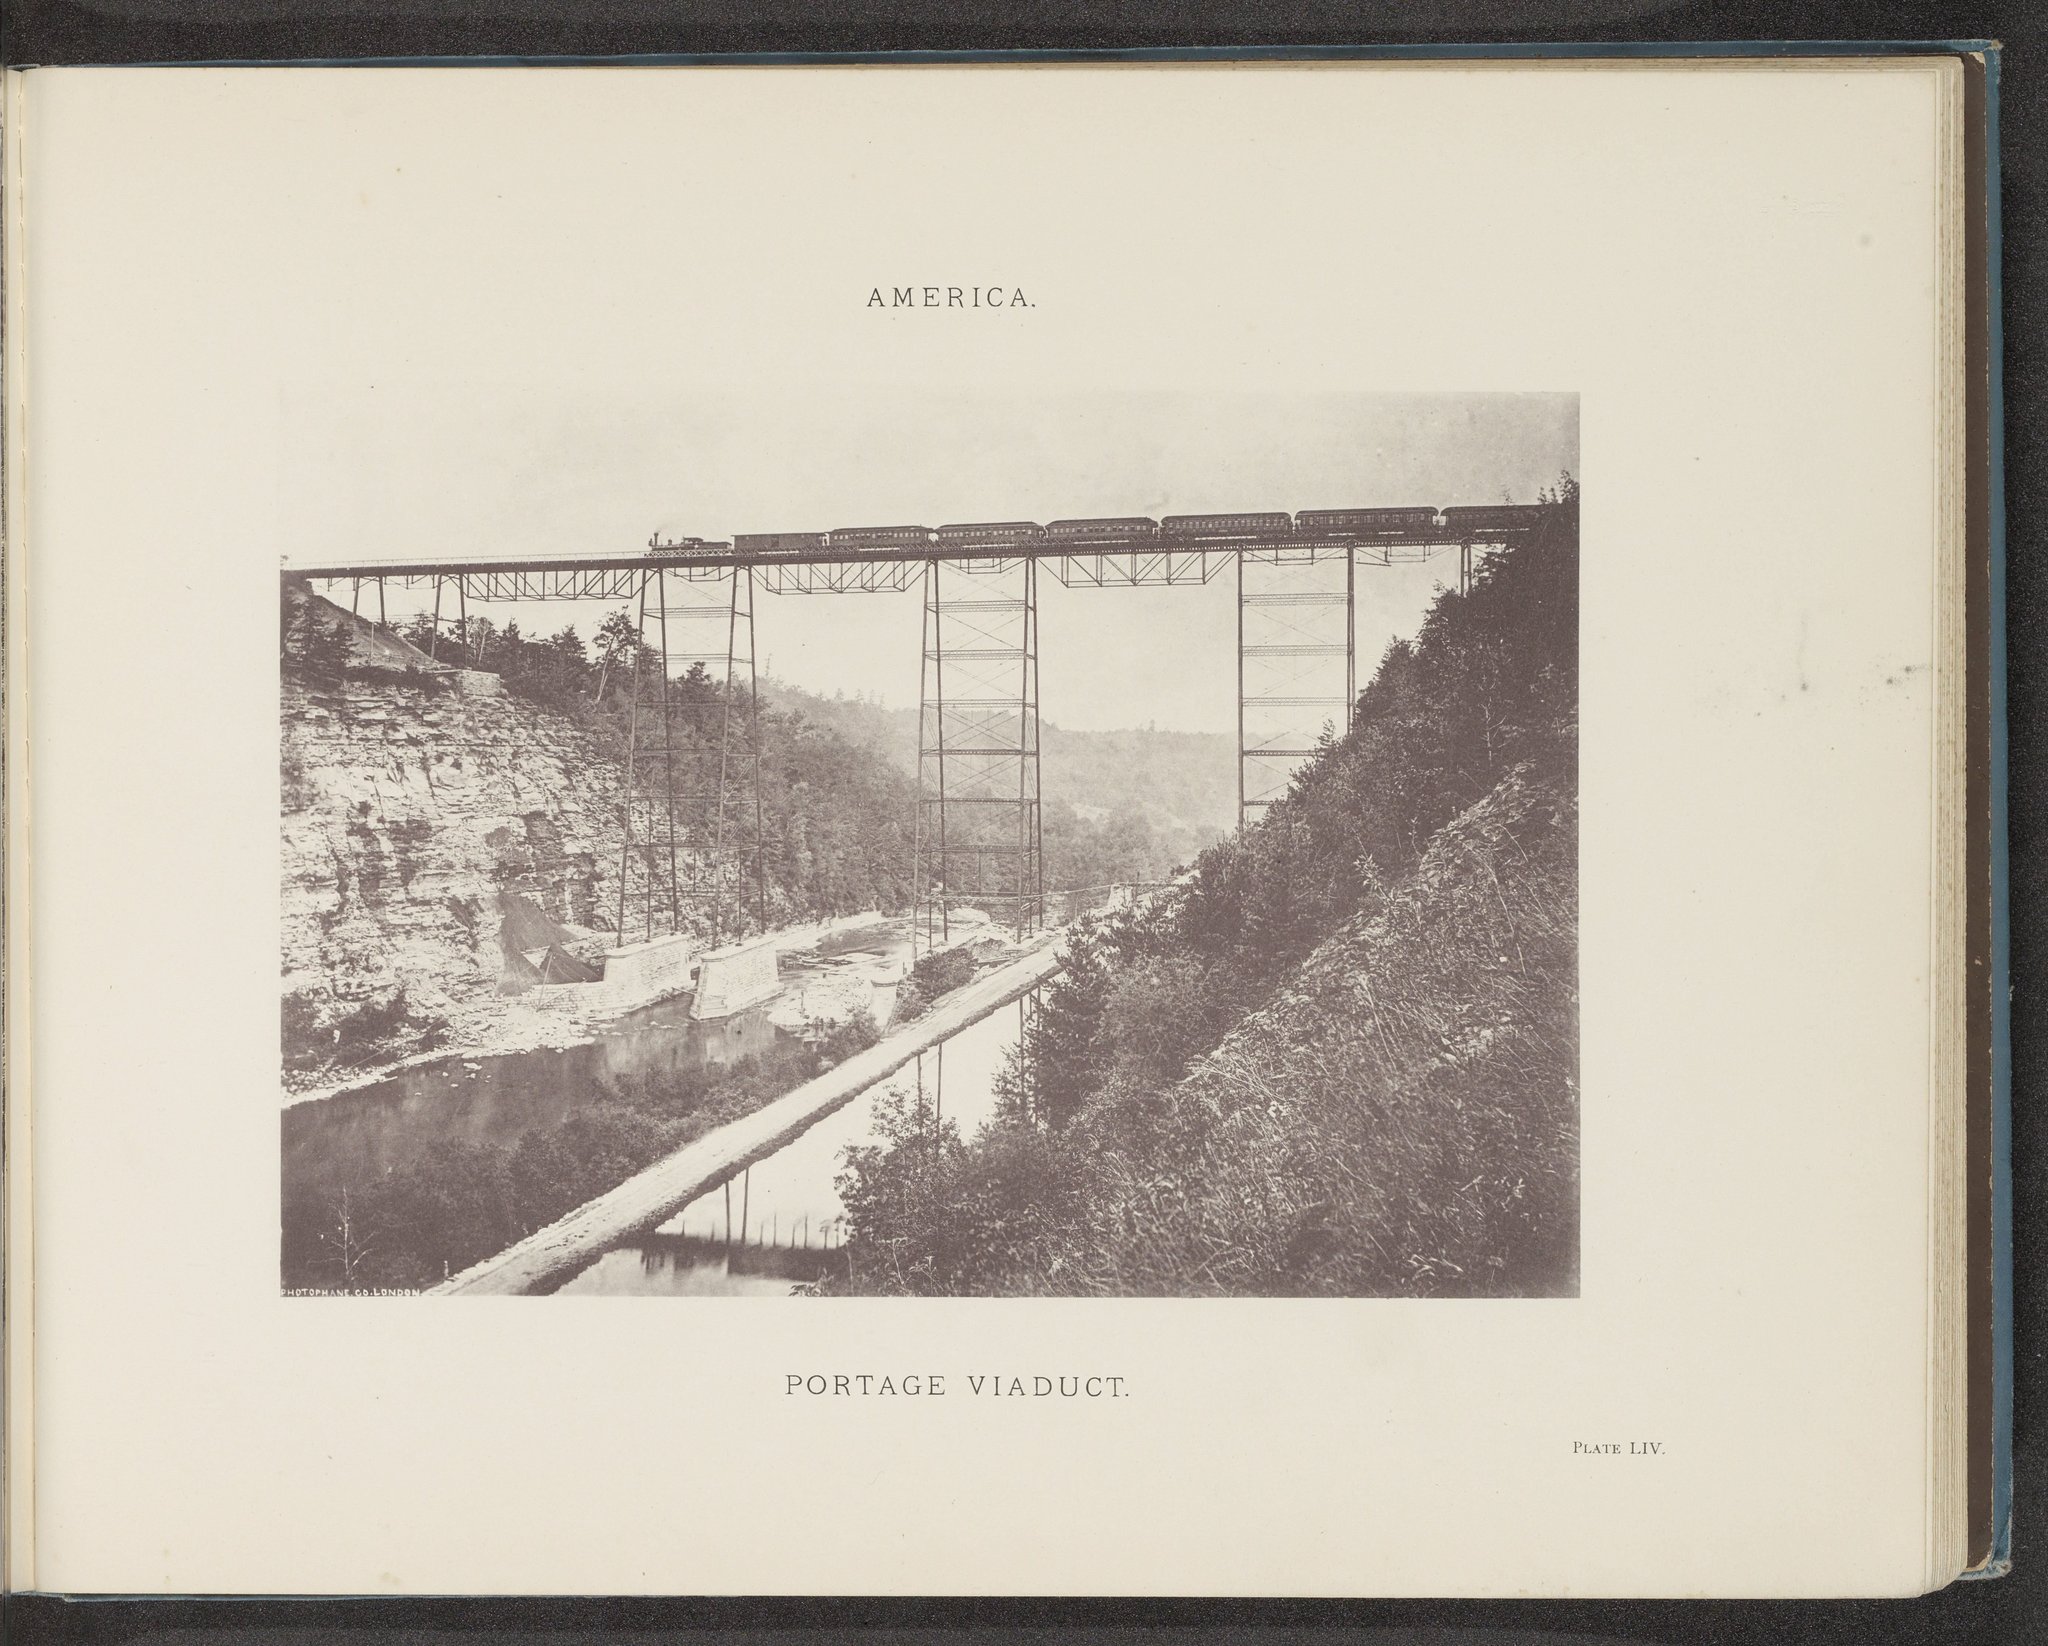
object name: photomechanical print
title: Portage Viaduct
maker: Anonymous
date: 1880-1890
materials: paper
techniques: photograph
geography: london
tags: landscape with bridge, viaduct or aqueduct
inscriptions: inscription: ‘America.’, number: ‘Plate LIV.’